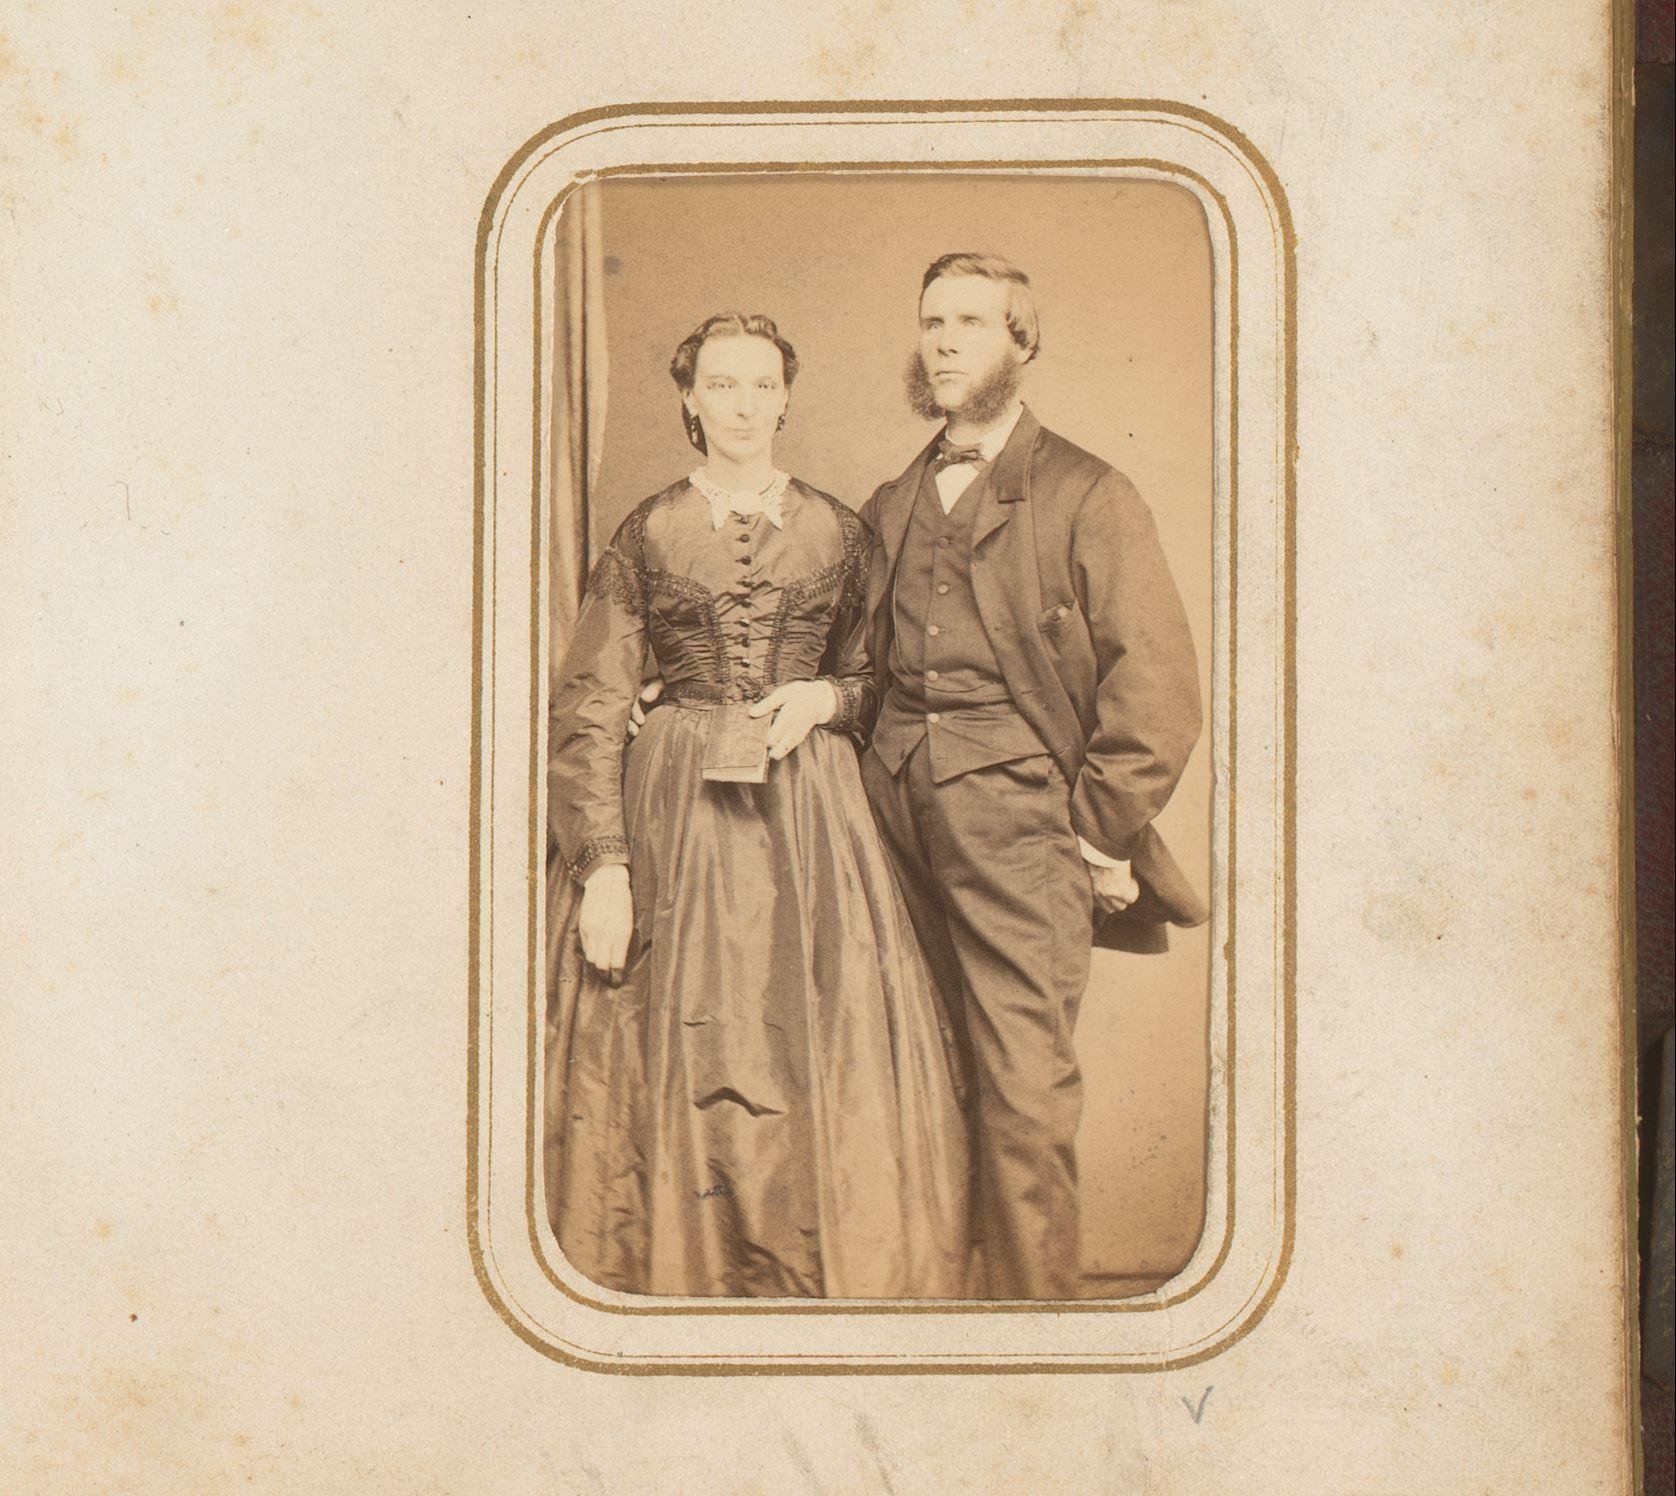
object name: photograph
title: Portret van een echtpaar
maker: louis robert werner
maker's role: fotograaf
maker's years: 1834-1896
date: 1861-1866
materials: cardboard, photographic support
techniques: albumen print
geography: amsterdam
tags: couple of lovers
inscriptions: inscription: ‘Photographisch Atelier/ L.R. Werner/ voorheen/ P. Carstensen/ Nieuwendijk H 201/ Amsterdam’